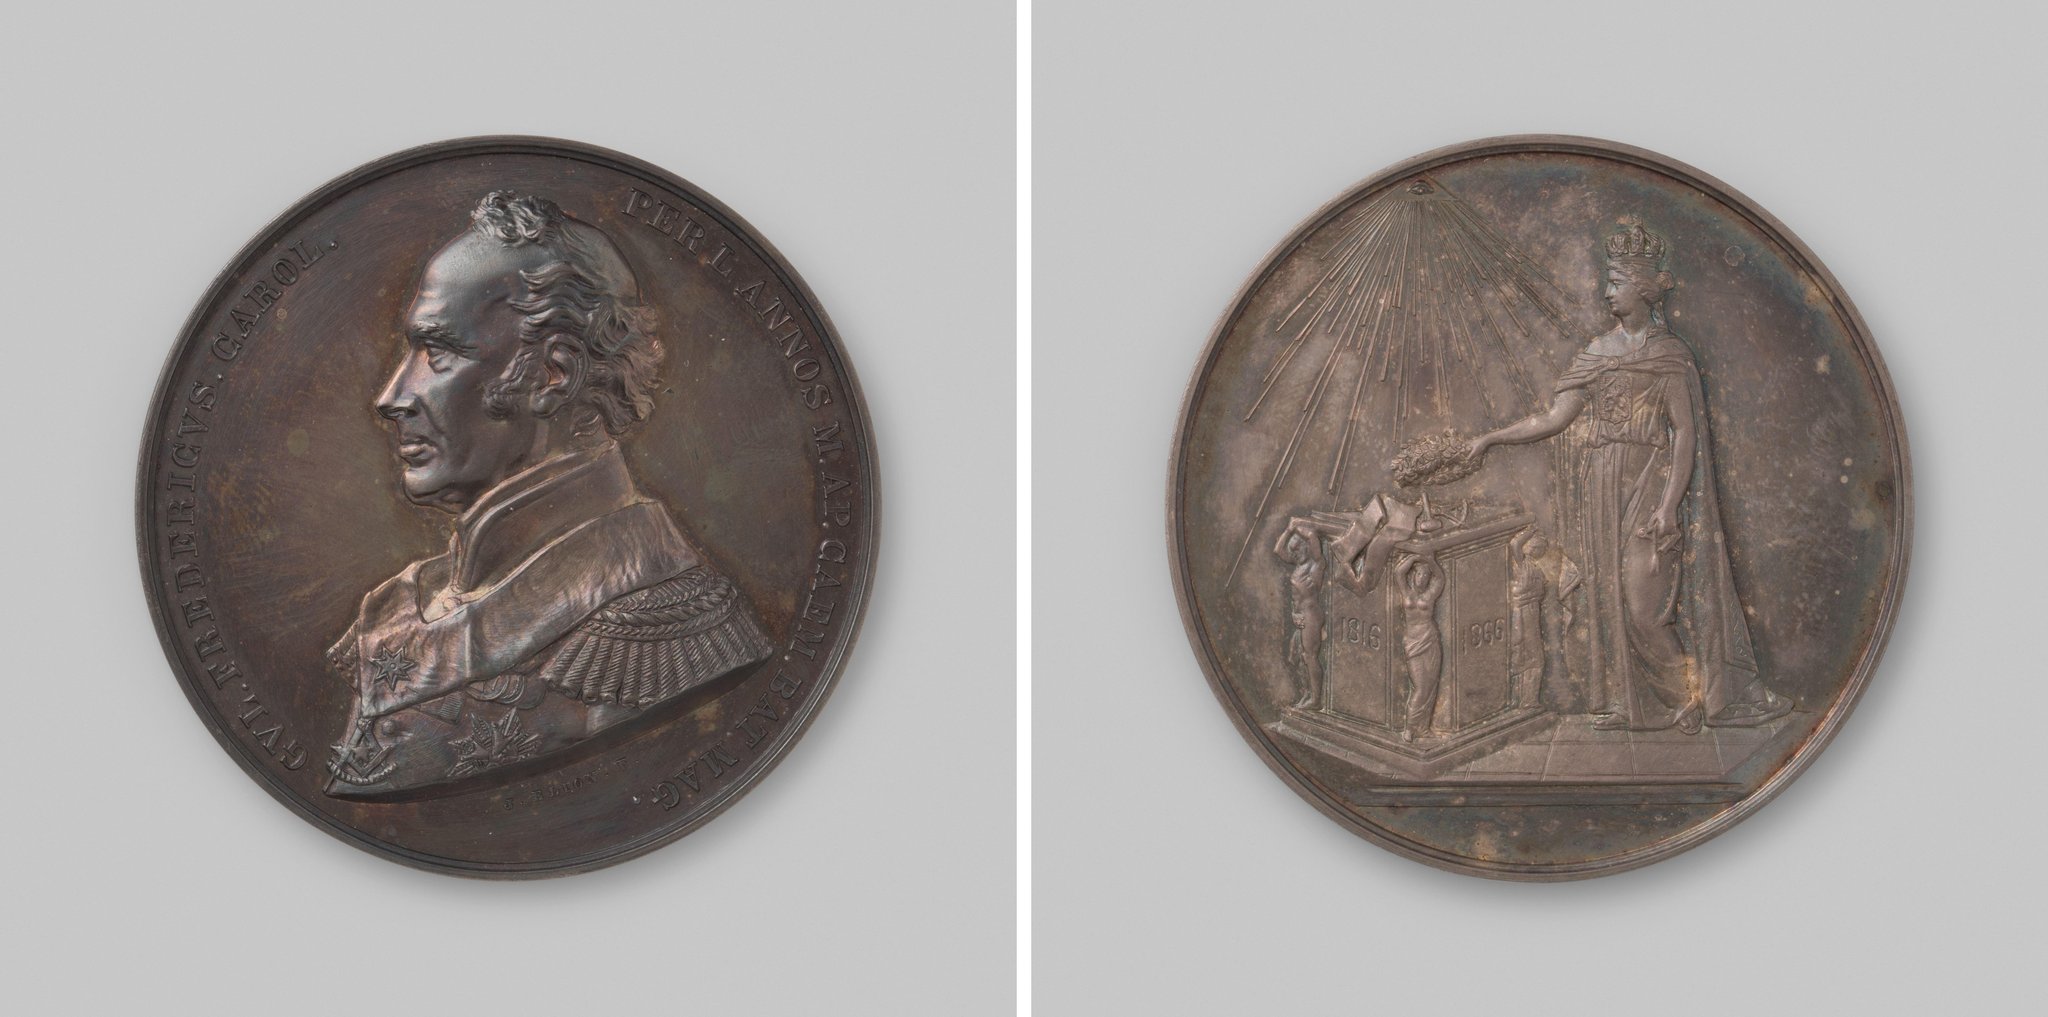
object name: honorary medal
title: Frederik, prins der Nederlanden, vijftig jaar grootmeester der vrijmetselarij, penning geslagen op last van de loge "Groot-Orient der Nederlanden"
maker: jacob samuel cohen elion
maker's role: draughtsman, painter, print maker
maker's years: 1840-1893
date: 1866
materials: silver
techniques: striking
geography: amsterdam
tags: berlin, frederik (prins der nederlanden)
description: Zilveren penning. Voorzijde: borststuk man binnen omschrift. Keerzijde: beschenen door alziend oog in stralende driehoek houdt Nederland, voorgesteld als gekroonde vrouw, winkelhaak en cirkel in linkerhand en legt met andere hand lauwerkrans op altaar, waarop grootmeesterteken